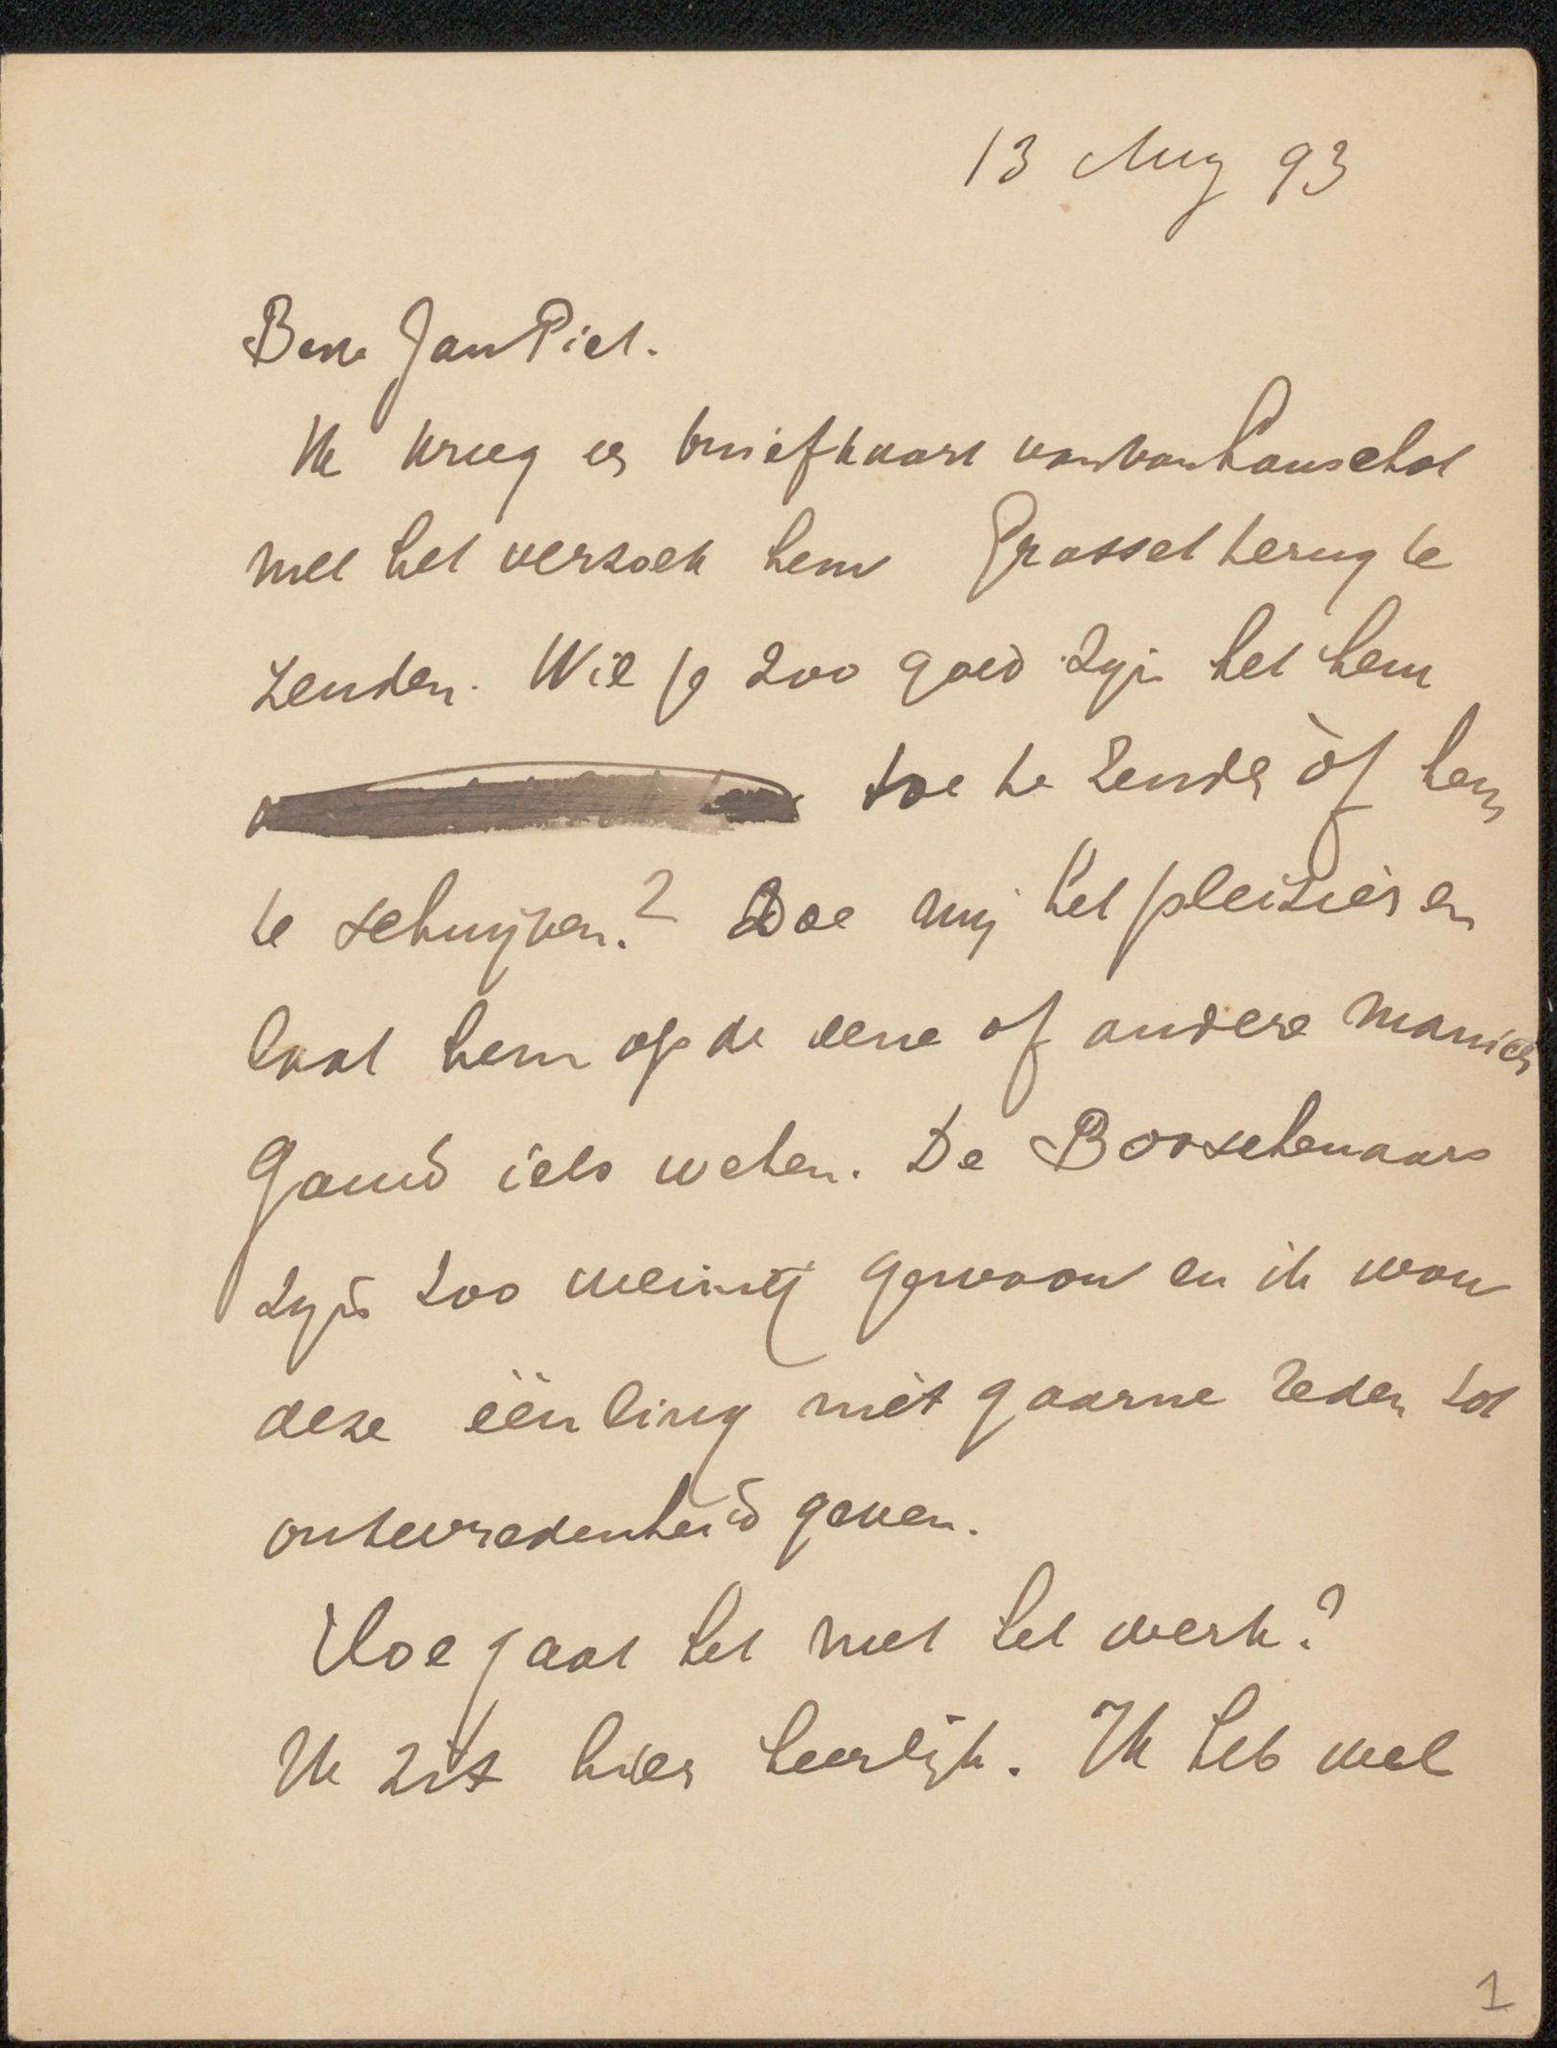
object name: letter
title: Brief aan Jan Veth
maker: antoon derkinderen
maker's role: draughtsman, painter, print maker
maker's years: 1859-1925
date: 1874-1925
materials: ink, paper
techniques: pen, writing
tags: dordrecht, amsterdam, painter, print maker, draughtsman, designer, jan veth, applied arts, arts and crafts; industrial design, painting (including book-illumination, miniature-painting), utrecht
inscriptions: collector's mark: ‘RPK’